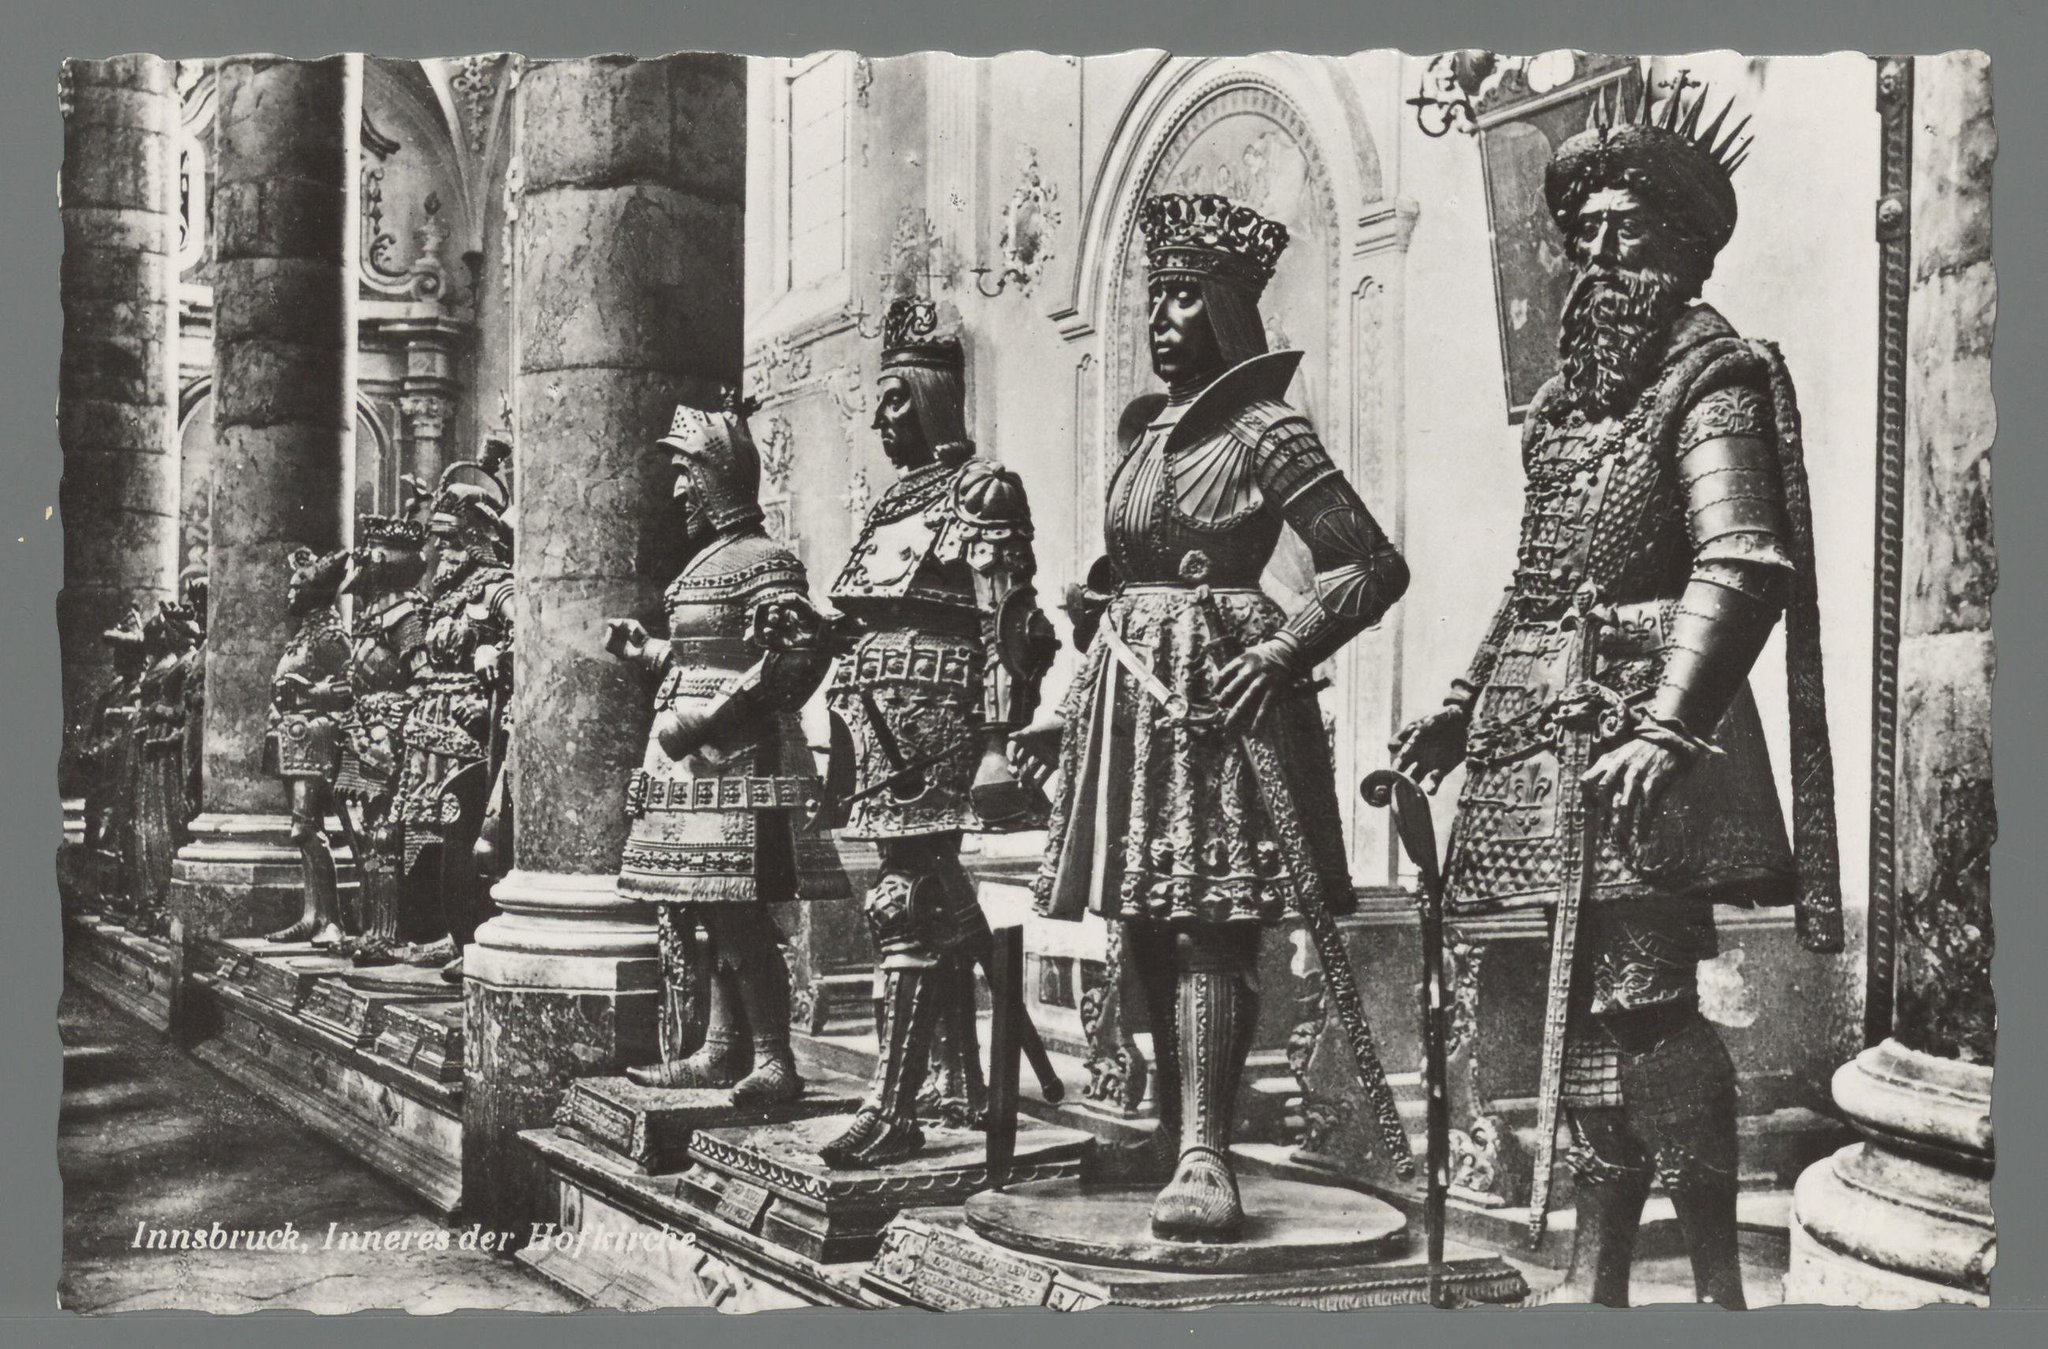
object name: photograph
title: Innsbruck, Inneres der Hofkirche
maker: Anonymous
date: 1924-1950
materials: paper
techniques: gelatin silver print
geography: innsbruck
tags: statues, paintings, etc. ~ objects of worship in roman religion, interior of church